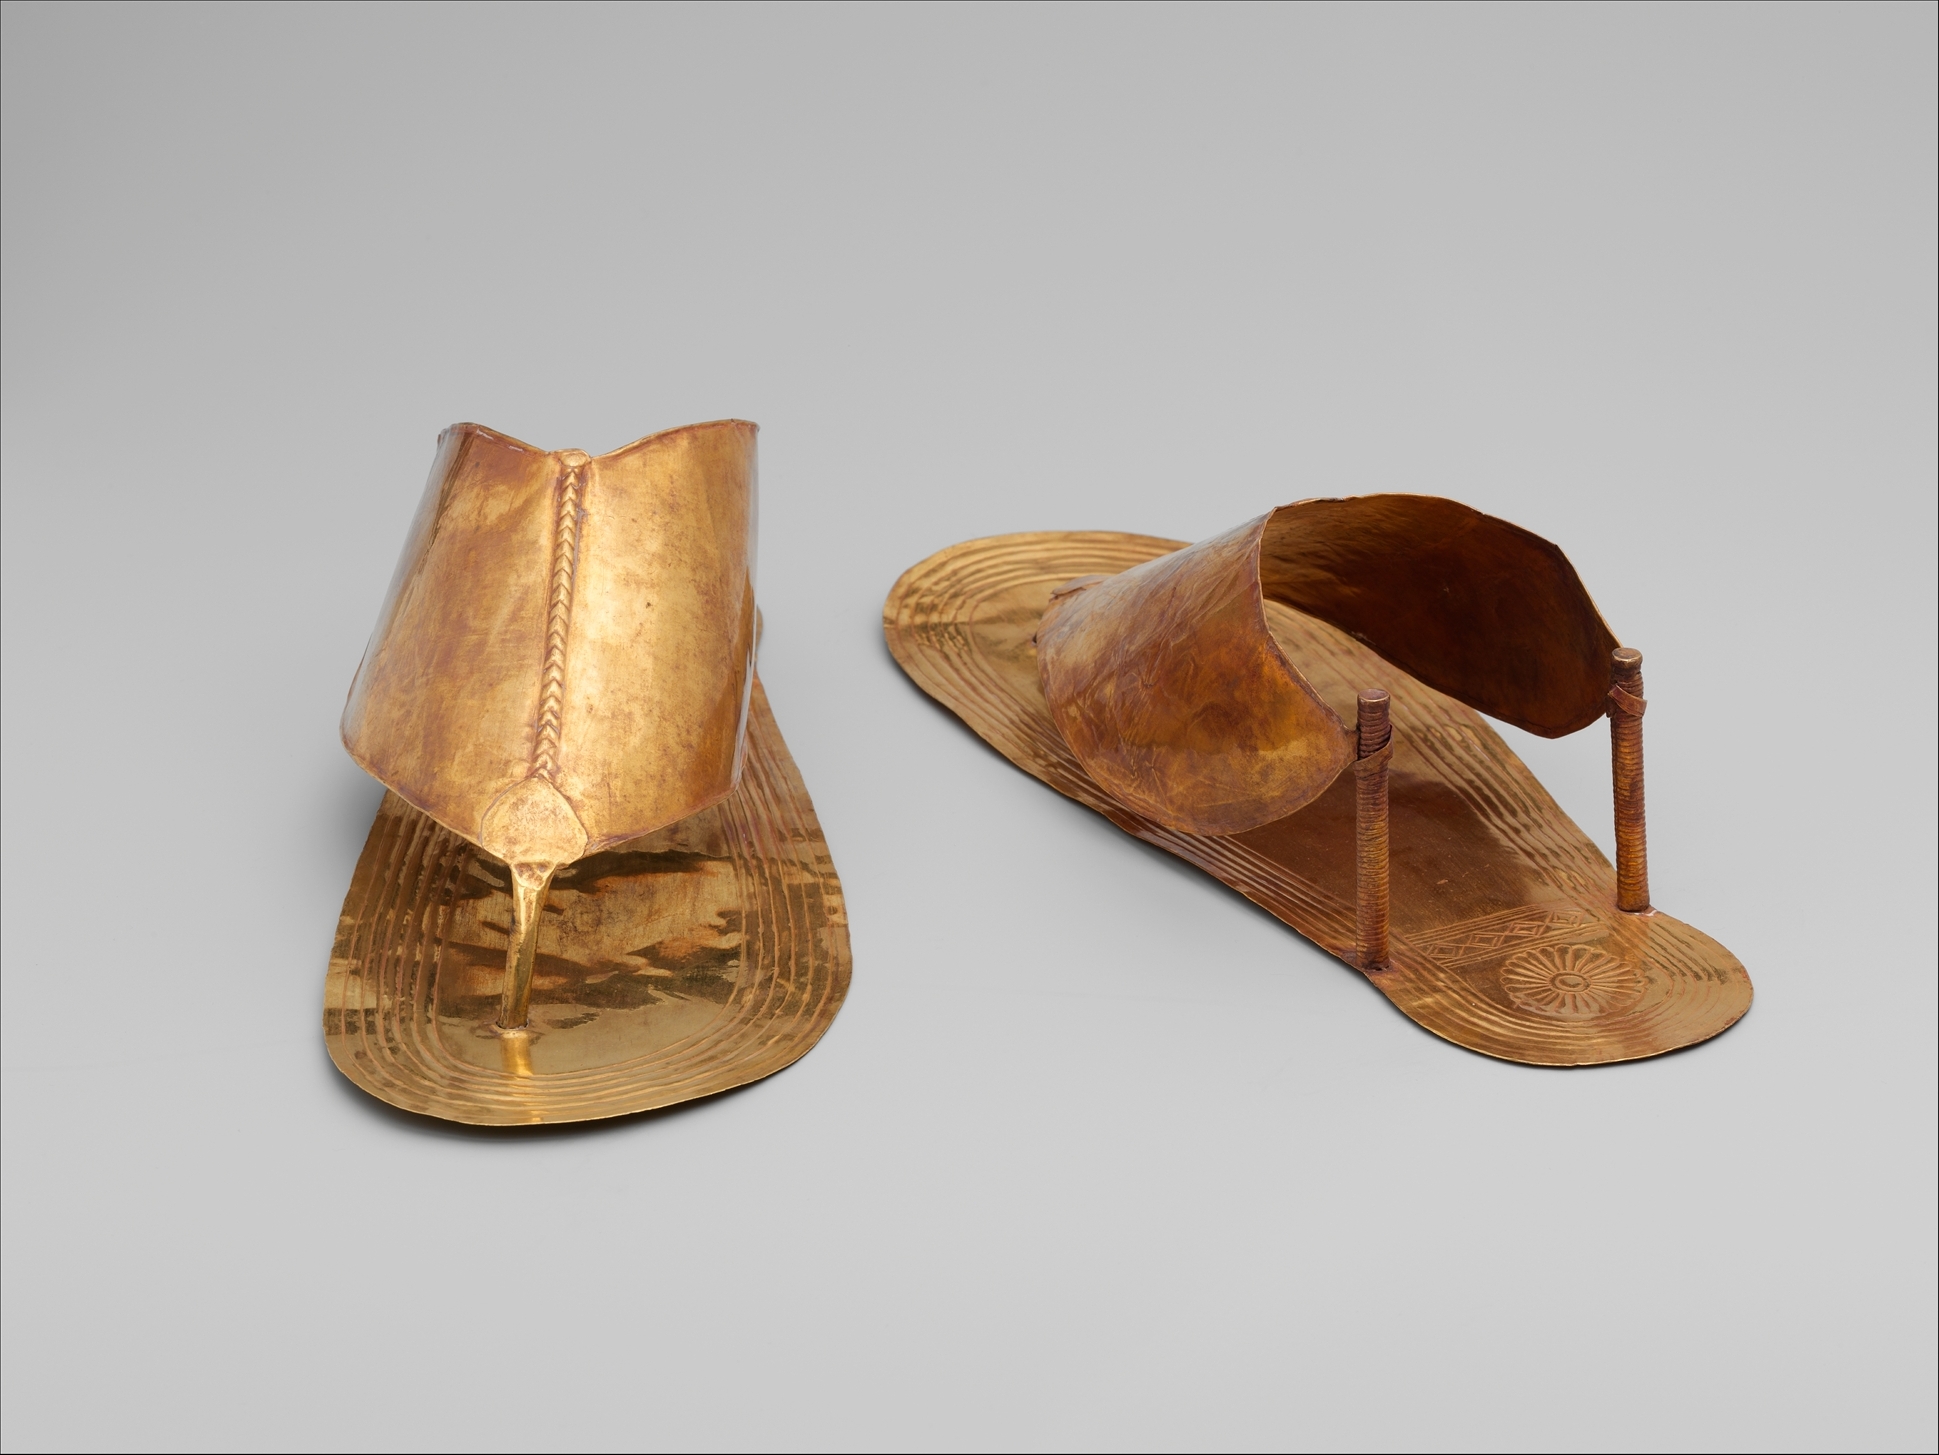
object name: pair of funerary sandal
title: Sandals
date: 1479-1425 BCE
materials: gold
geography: egypt